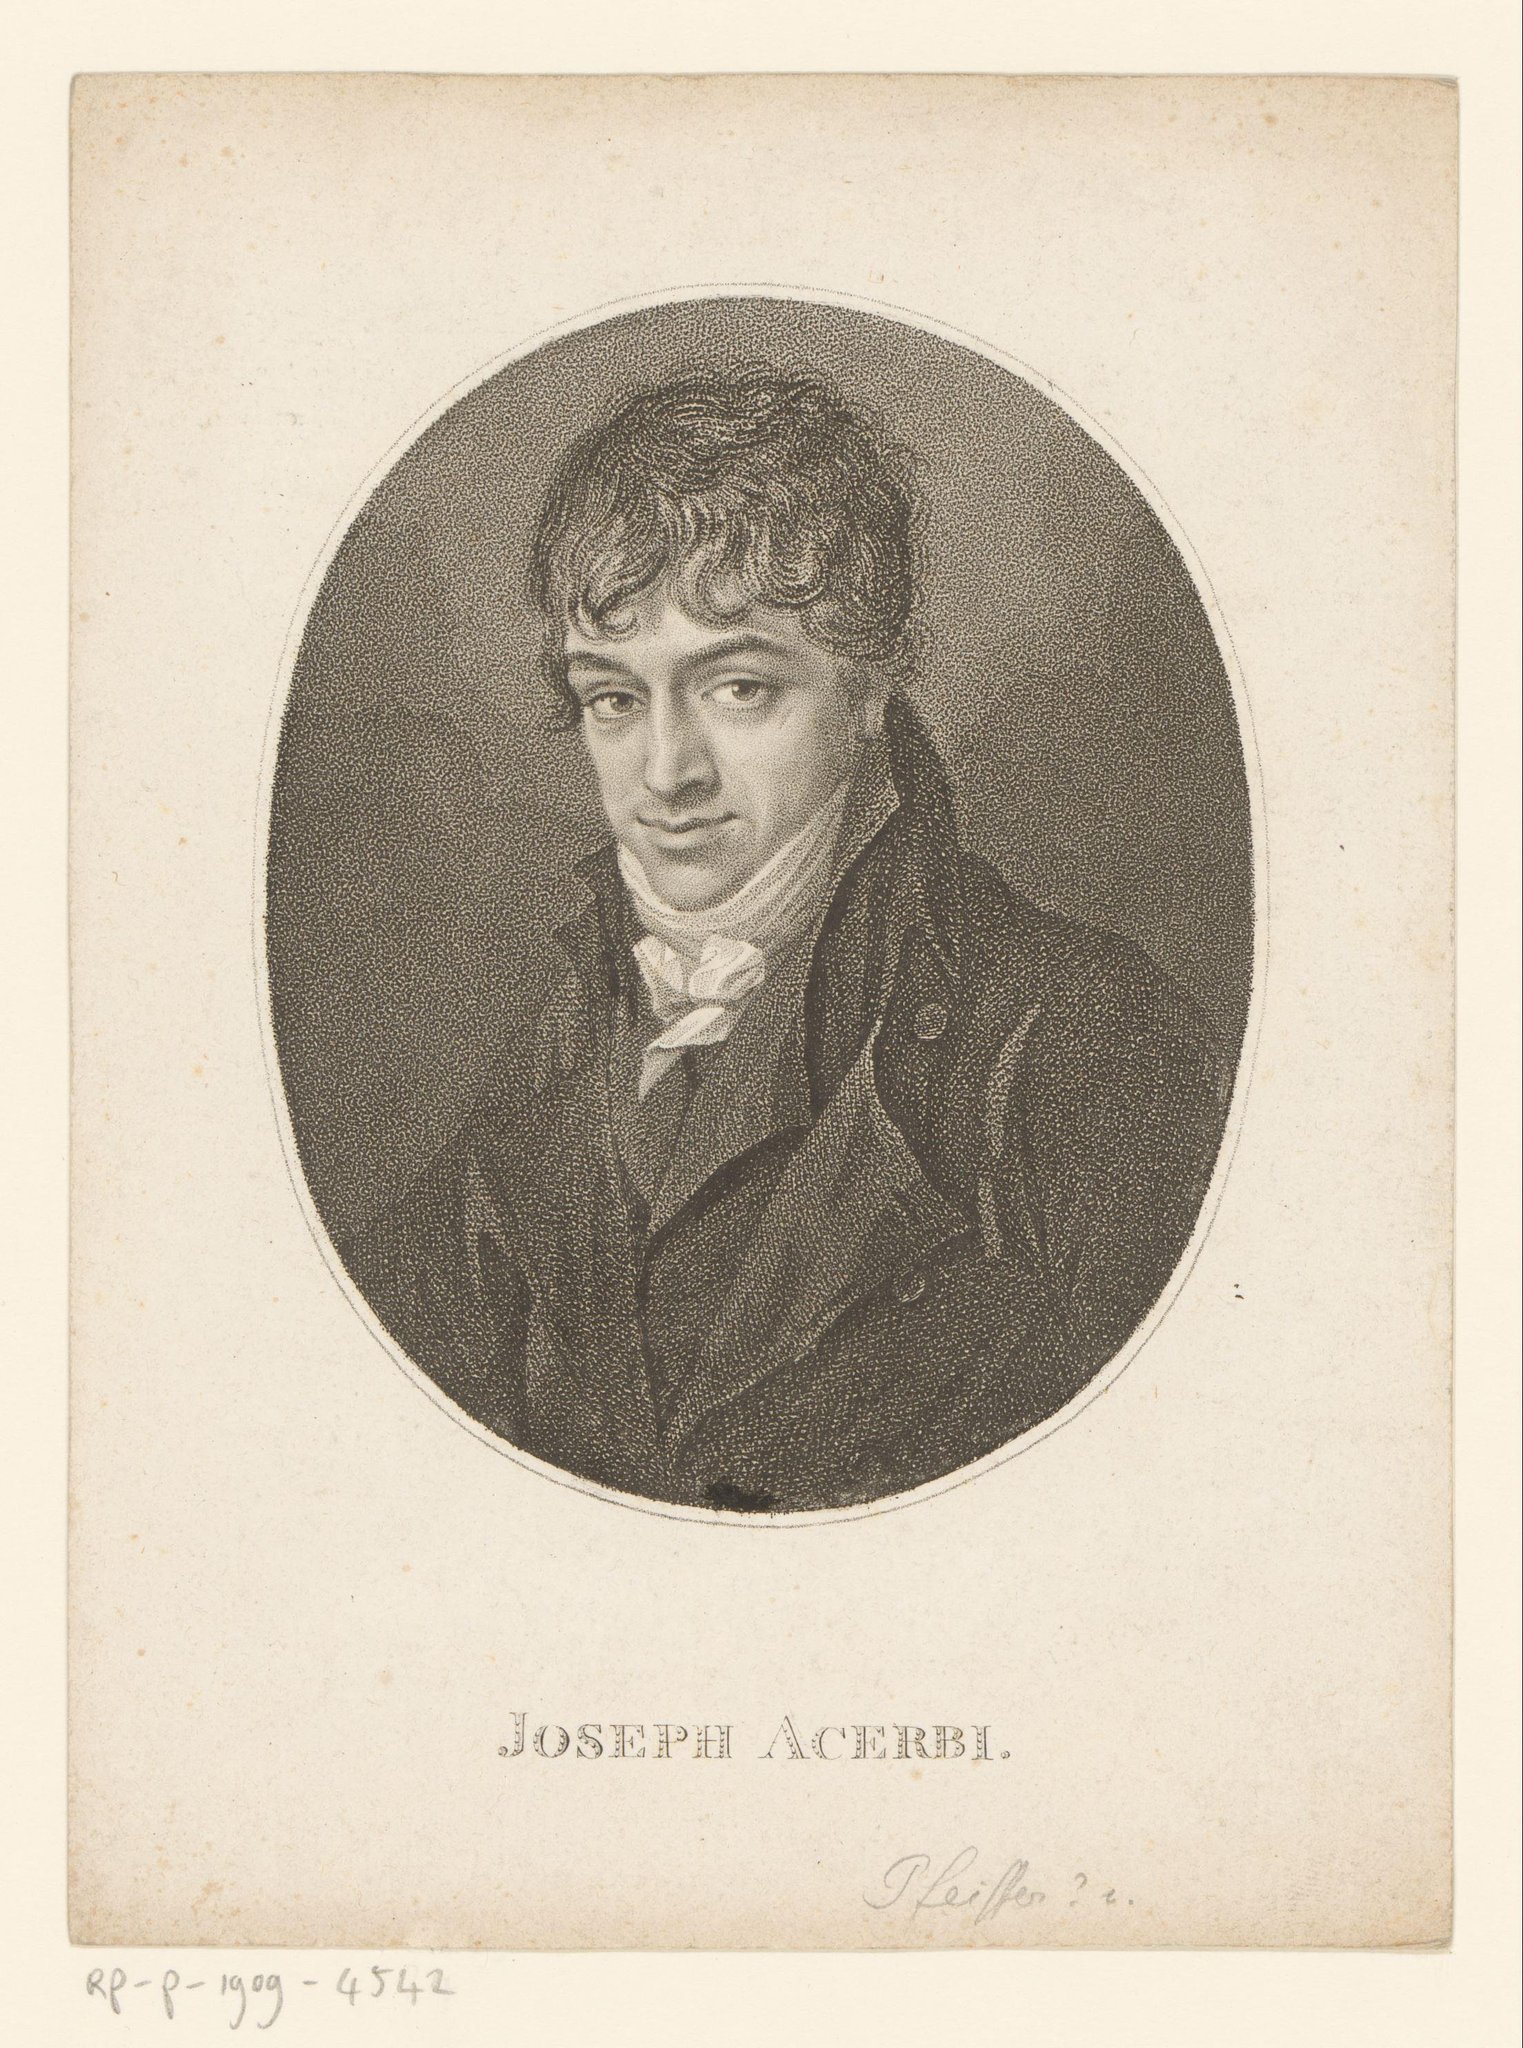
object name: print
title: Portret van Guiseppe Acerbi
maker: carl hermann pfeiffer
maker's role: print maker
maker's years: 1769-1829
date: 1783-1829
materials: paper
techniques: stippled etching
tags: historical persons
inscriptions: collector's mark: Lugt 2228